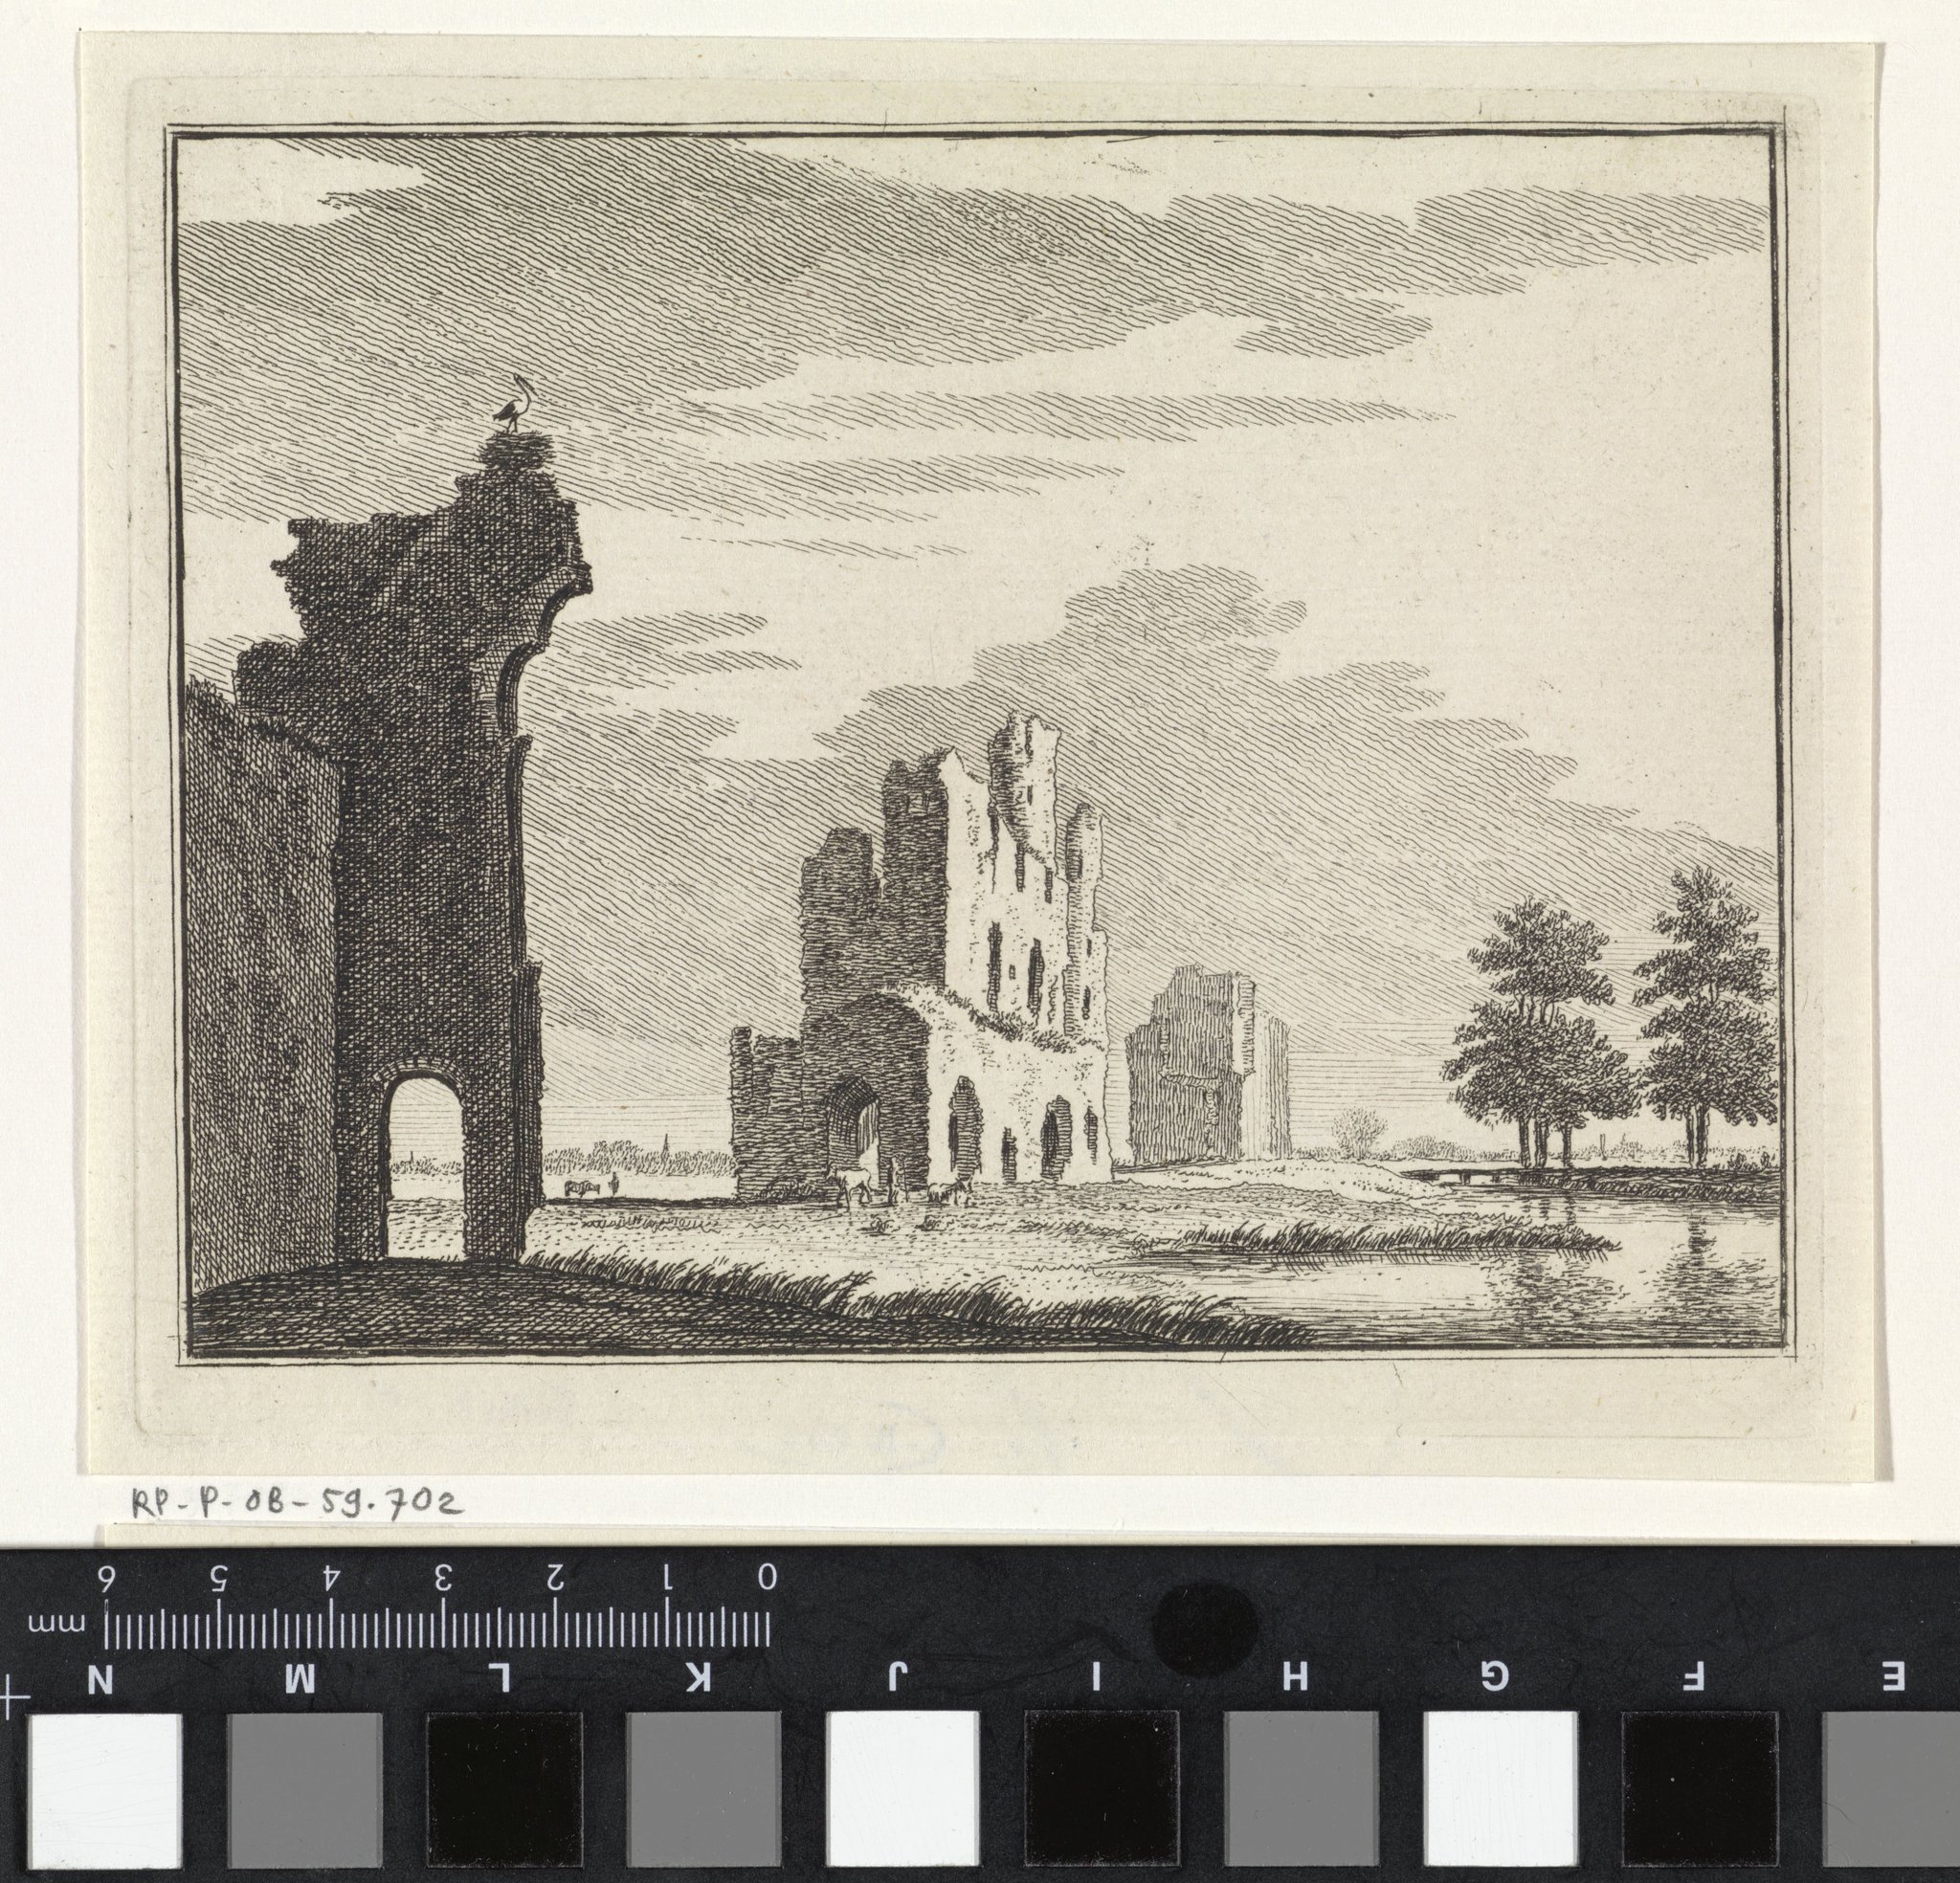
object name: print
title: Rivierlandschap met ruïnes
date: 1742-1784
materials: paper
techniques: etching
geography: amsterdam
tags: shore-birds and wading-birds: stork, river, landscape with ruins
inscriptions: collector's mark: Lugt 2228